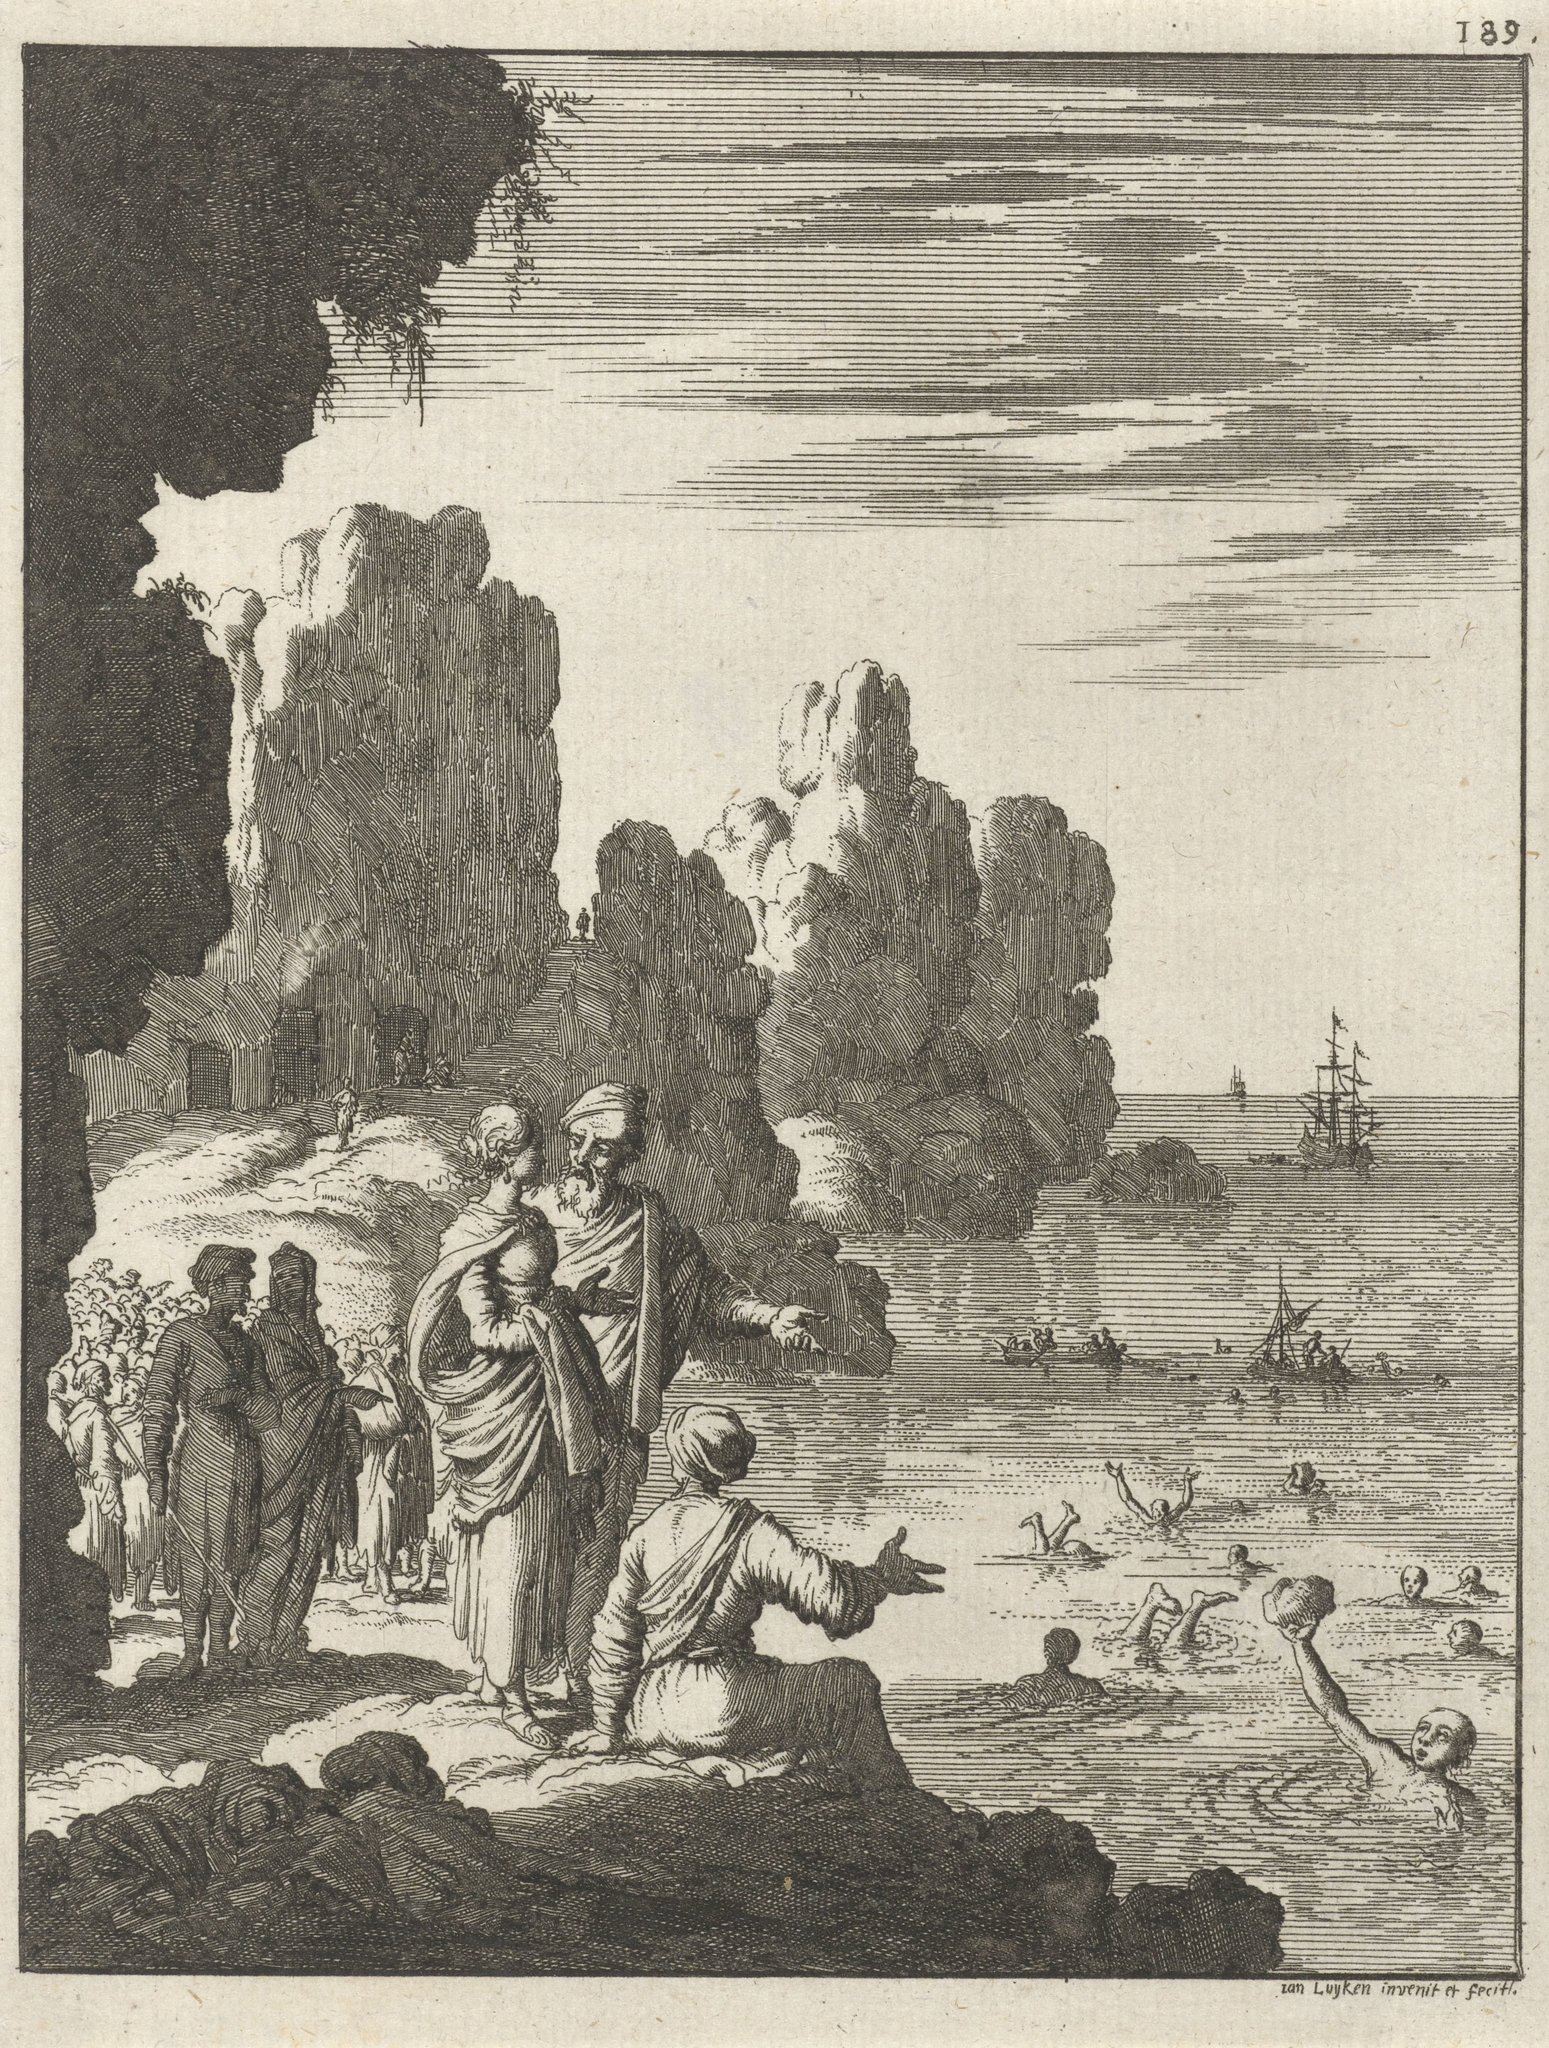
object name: print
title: Uithuwelijking van de meisjes op Chios aan de beste zwemmer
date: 1681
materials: paper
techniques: etching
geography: amsterdam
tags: swimming (movement in water), ideal husband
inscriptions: collector's mark: Lugt 2228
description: Illustratie opgenomen in deel I van: Thevenot, Jean de. Gedenkwaardige en zeer naauwkeurige reizen van den heere de Thevenot. Amsterdam: Jan Bouman, 1681-1682.